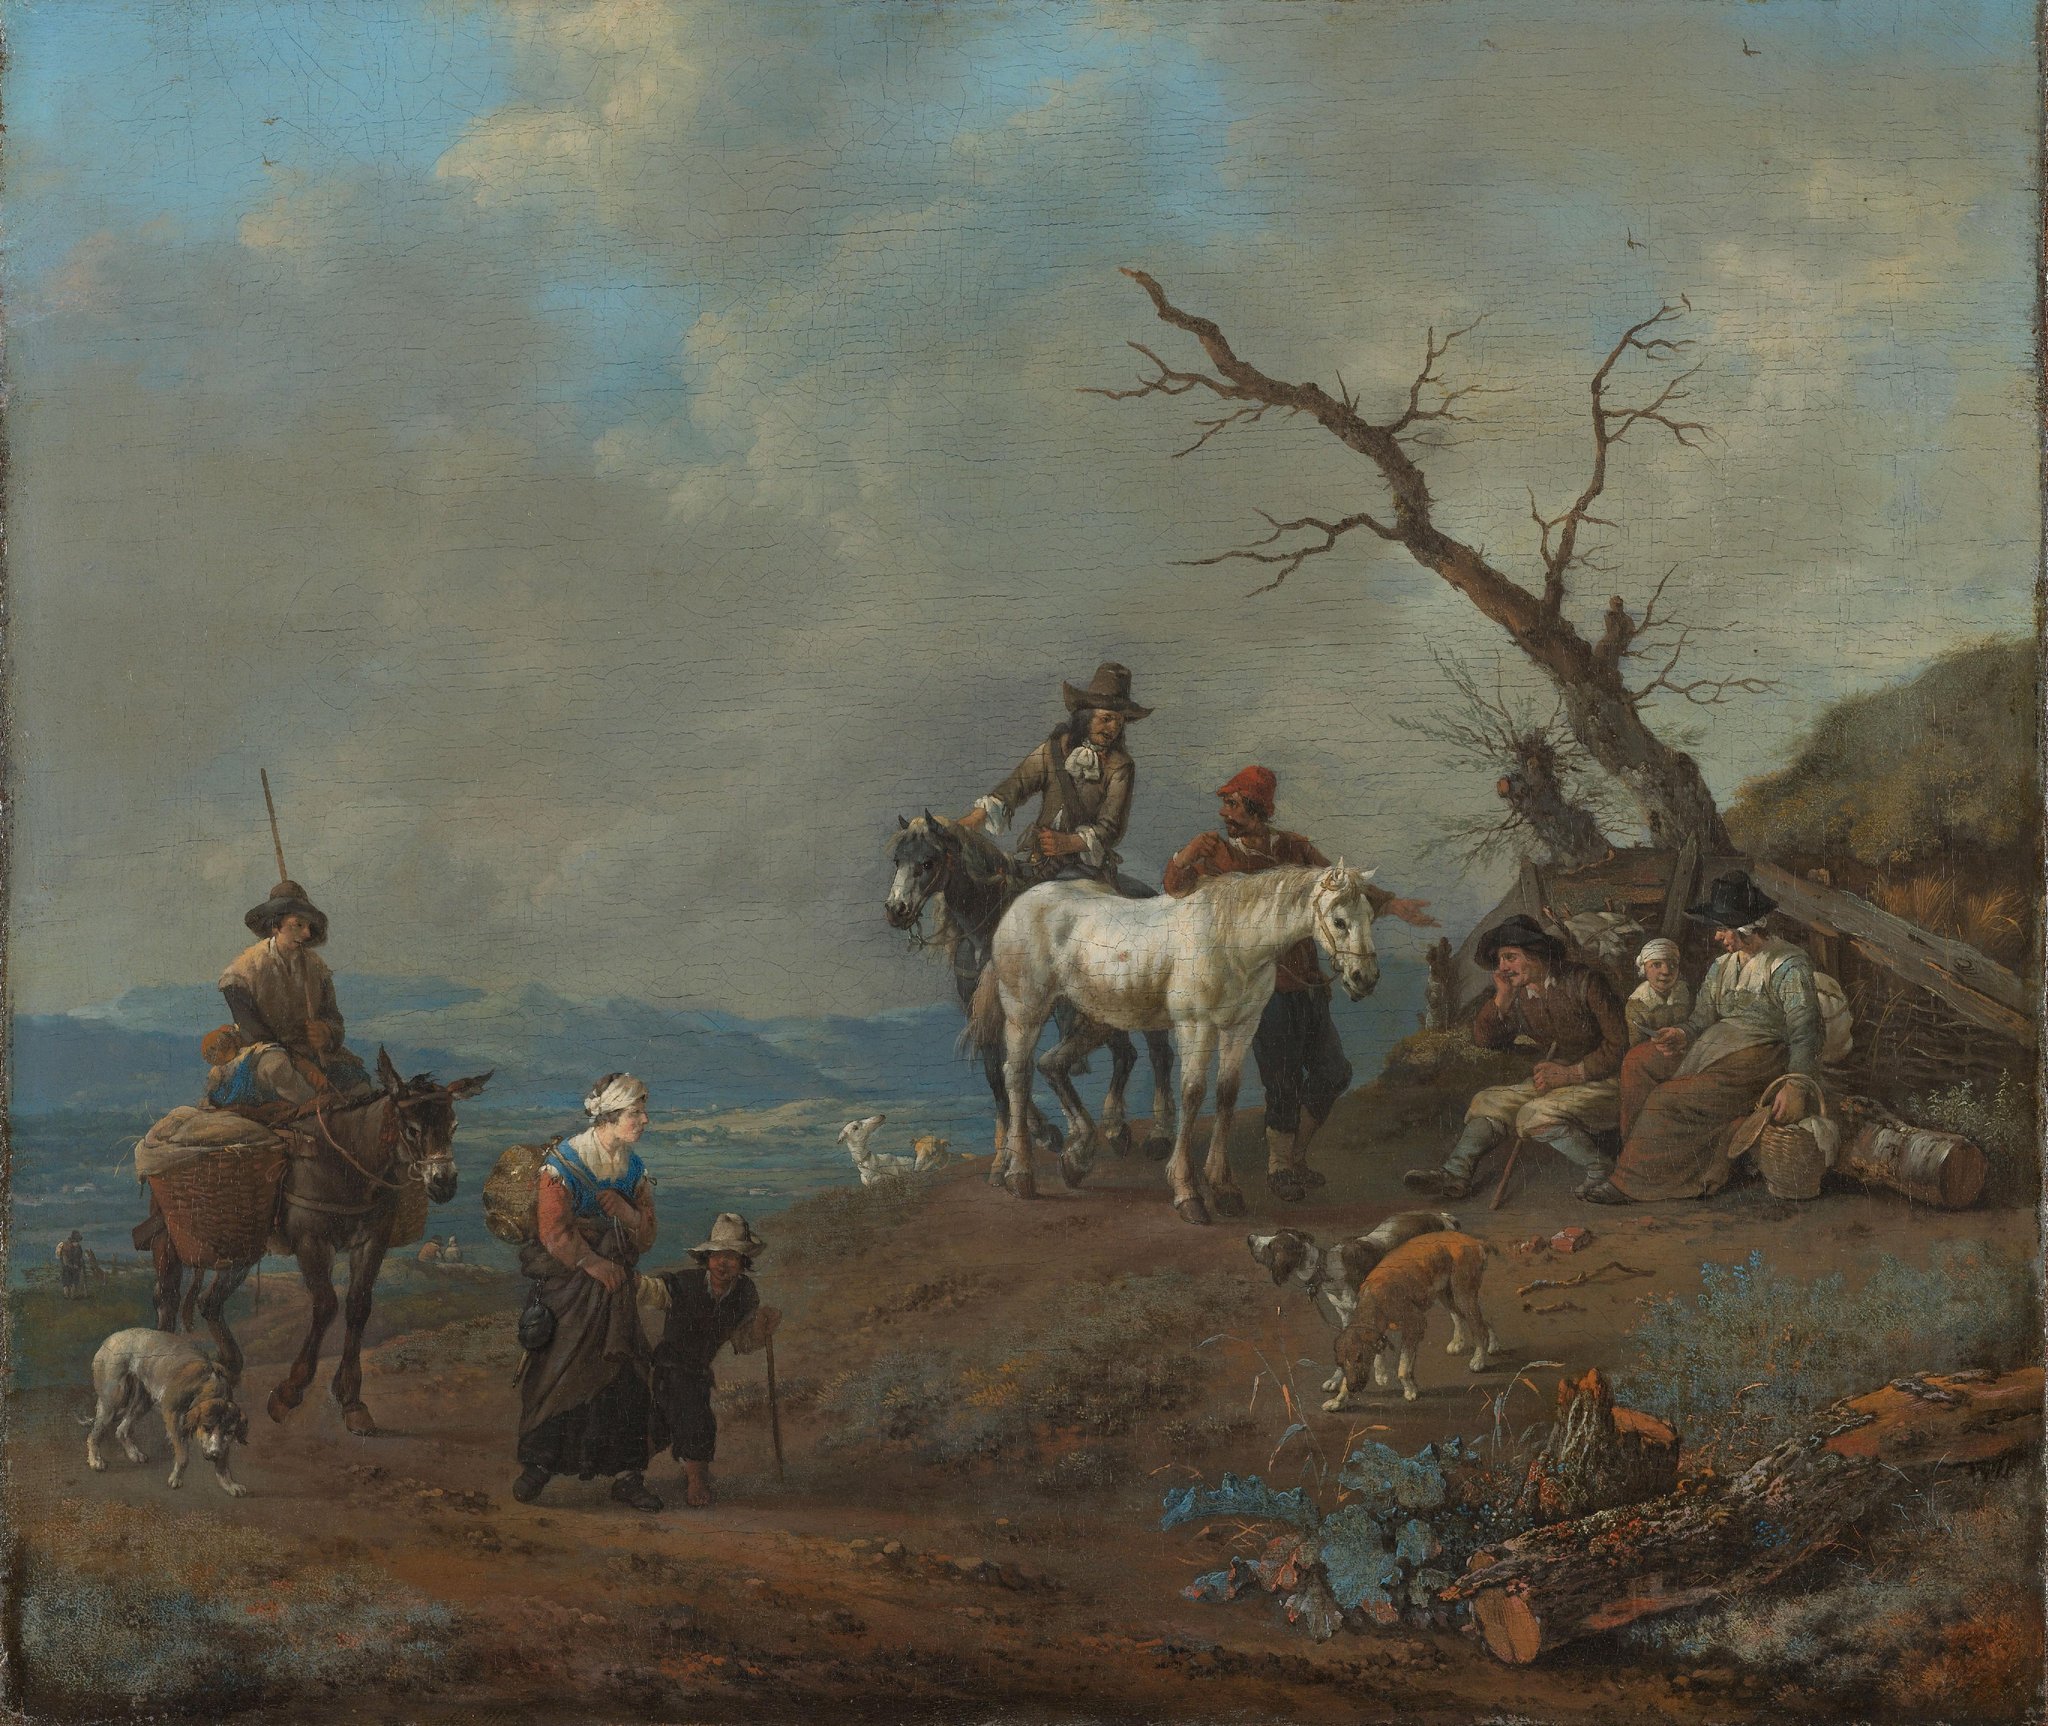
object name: painting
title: Country Road with Hunter and Peasants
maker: johannes lingelbach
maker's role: draughtsman, painter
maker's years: 1622-1674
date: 1650-1674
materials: canvas, oil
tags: riding a horse, ass, or mule; rider, horseman, hunter, 'en route', traveller under way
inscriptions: signature: ‘LB’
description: Landweg met links enkele reizgers. Rechts rust een familie bij een schutting, hierbij twee jagers met paarden en honden.